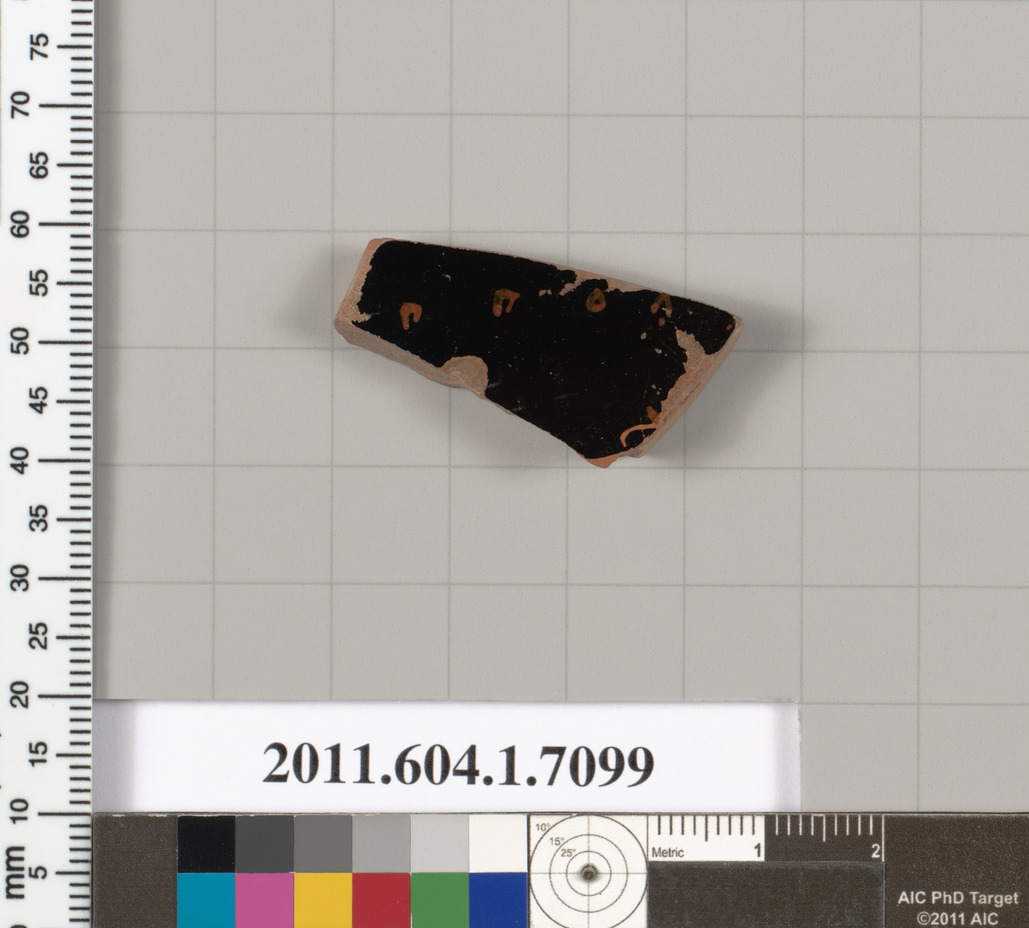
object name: kylix fragment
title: Terracotta fragment of a kylix (drinking cup)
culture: greek, attic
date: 500-480 BCE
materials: terracotta